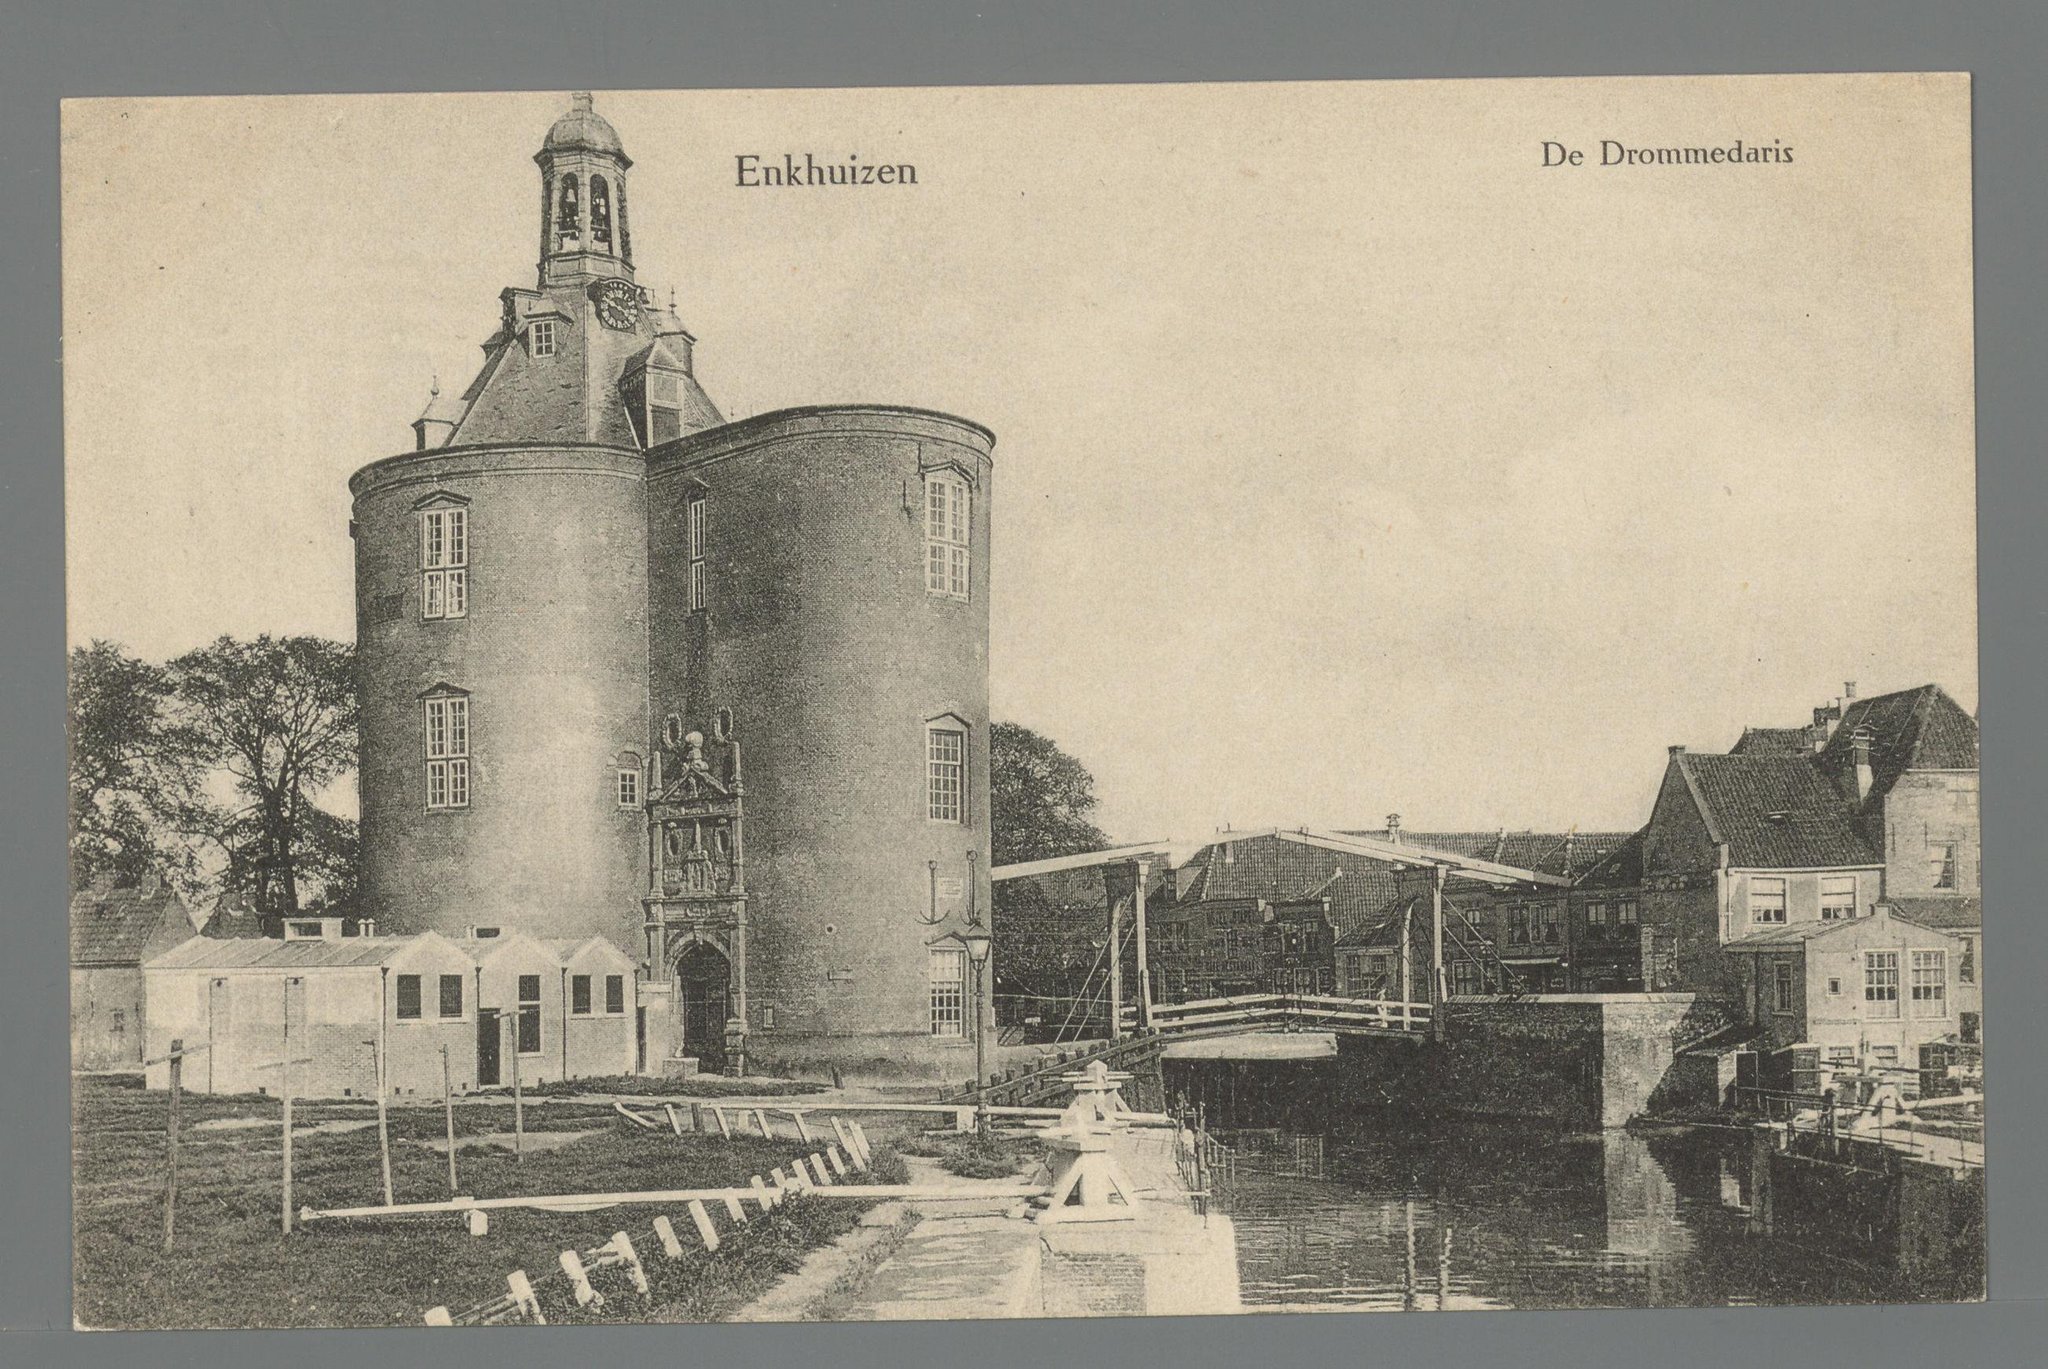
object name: photomechanical print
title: Enkhuizen. De Drommedaris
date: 1909-1912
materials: cardboard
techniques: photograph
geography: enkhuizen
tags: city-view, and landscape with man-made constructions, canals, waters (in city), bridge in city across river, canal, etc., city-gate, enkhuizen